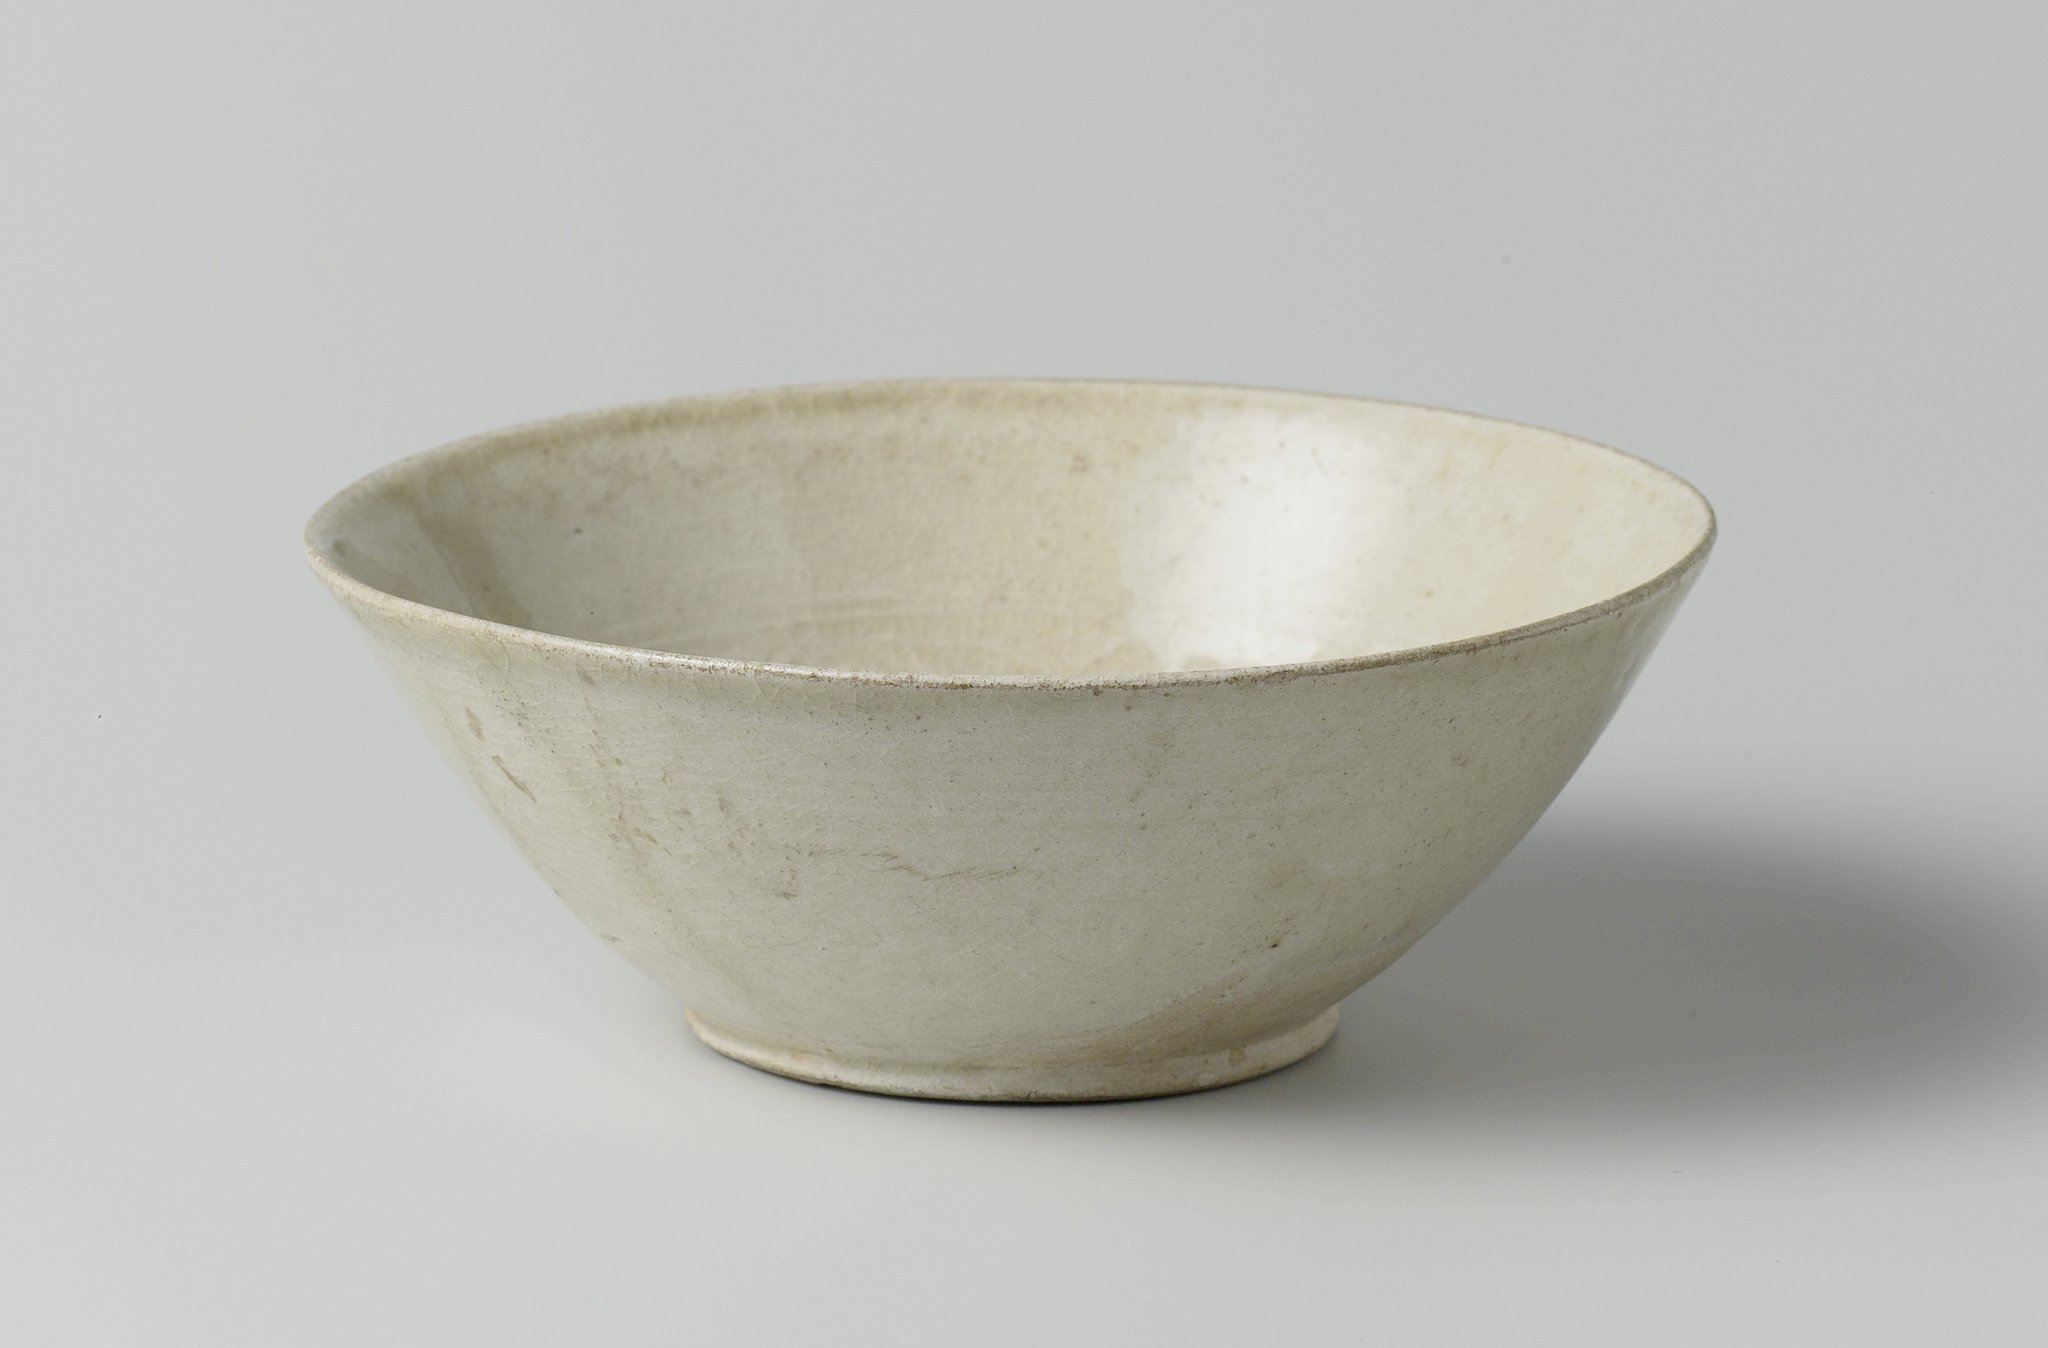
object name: bowl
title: Bowl with a border of floral scrolls in relief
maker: Anonymous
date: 1000-1200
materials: glaze, stoneware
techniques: firing, relief, turning, vitrification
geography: vietnam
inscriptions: label: ‘Village de Vinh-Phuc près de Hanoi (Tonkin). Emplacement de l'ancienne captitale Dai Là Thanh’, inscription: ‘Fabrication présumée Chinoise’, label: ‘Certainement de XIIIe Siècle ou même antérieur’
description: Kom van steengoed, bedekt met een lichtgroen glazuur. Op de binnenzijde een band met bloemranken in reliëf. De onderzijde is ongeglazuurd. Oude labels op de onderzijde met 'Certainement de XIIIe Siècle ou même antérieur', 'Village de Vinh-Phuc près de Hanoi (Tonkin). Emplacement de l'ancienne captitale Dai Là Thanh', 'Fabrication présumée Chinoise'.